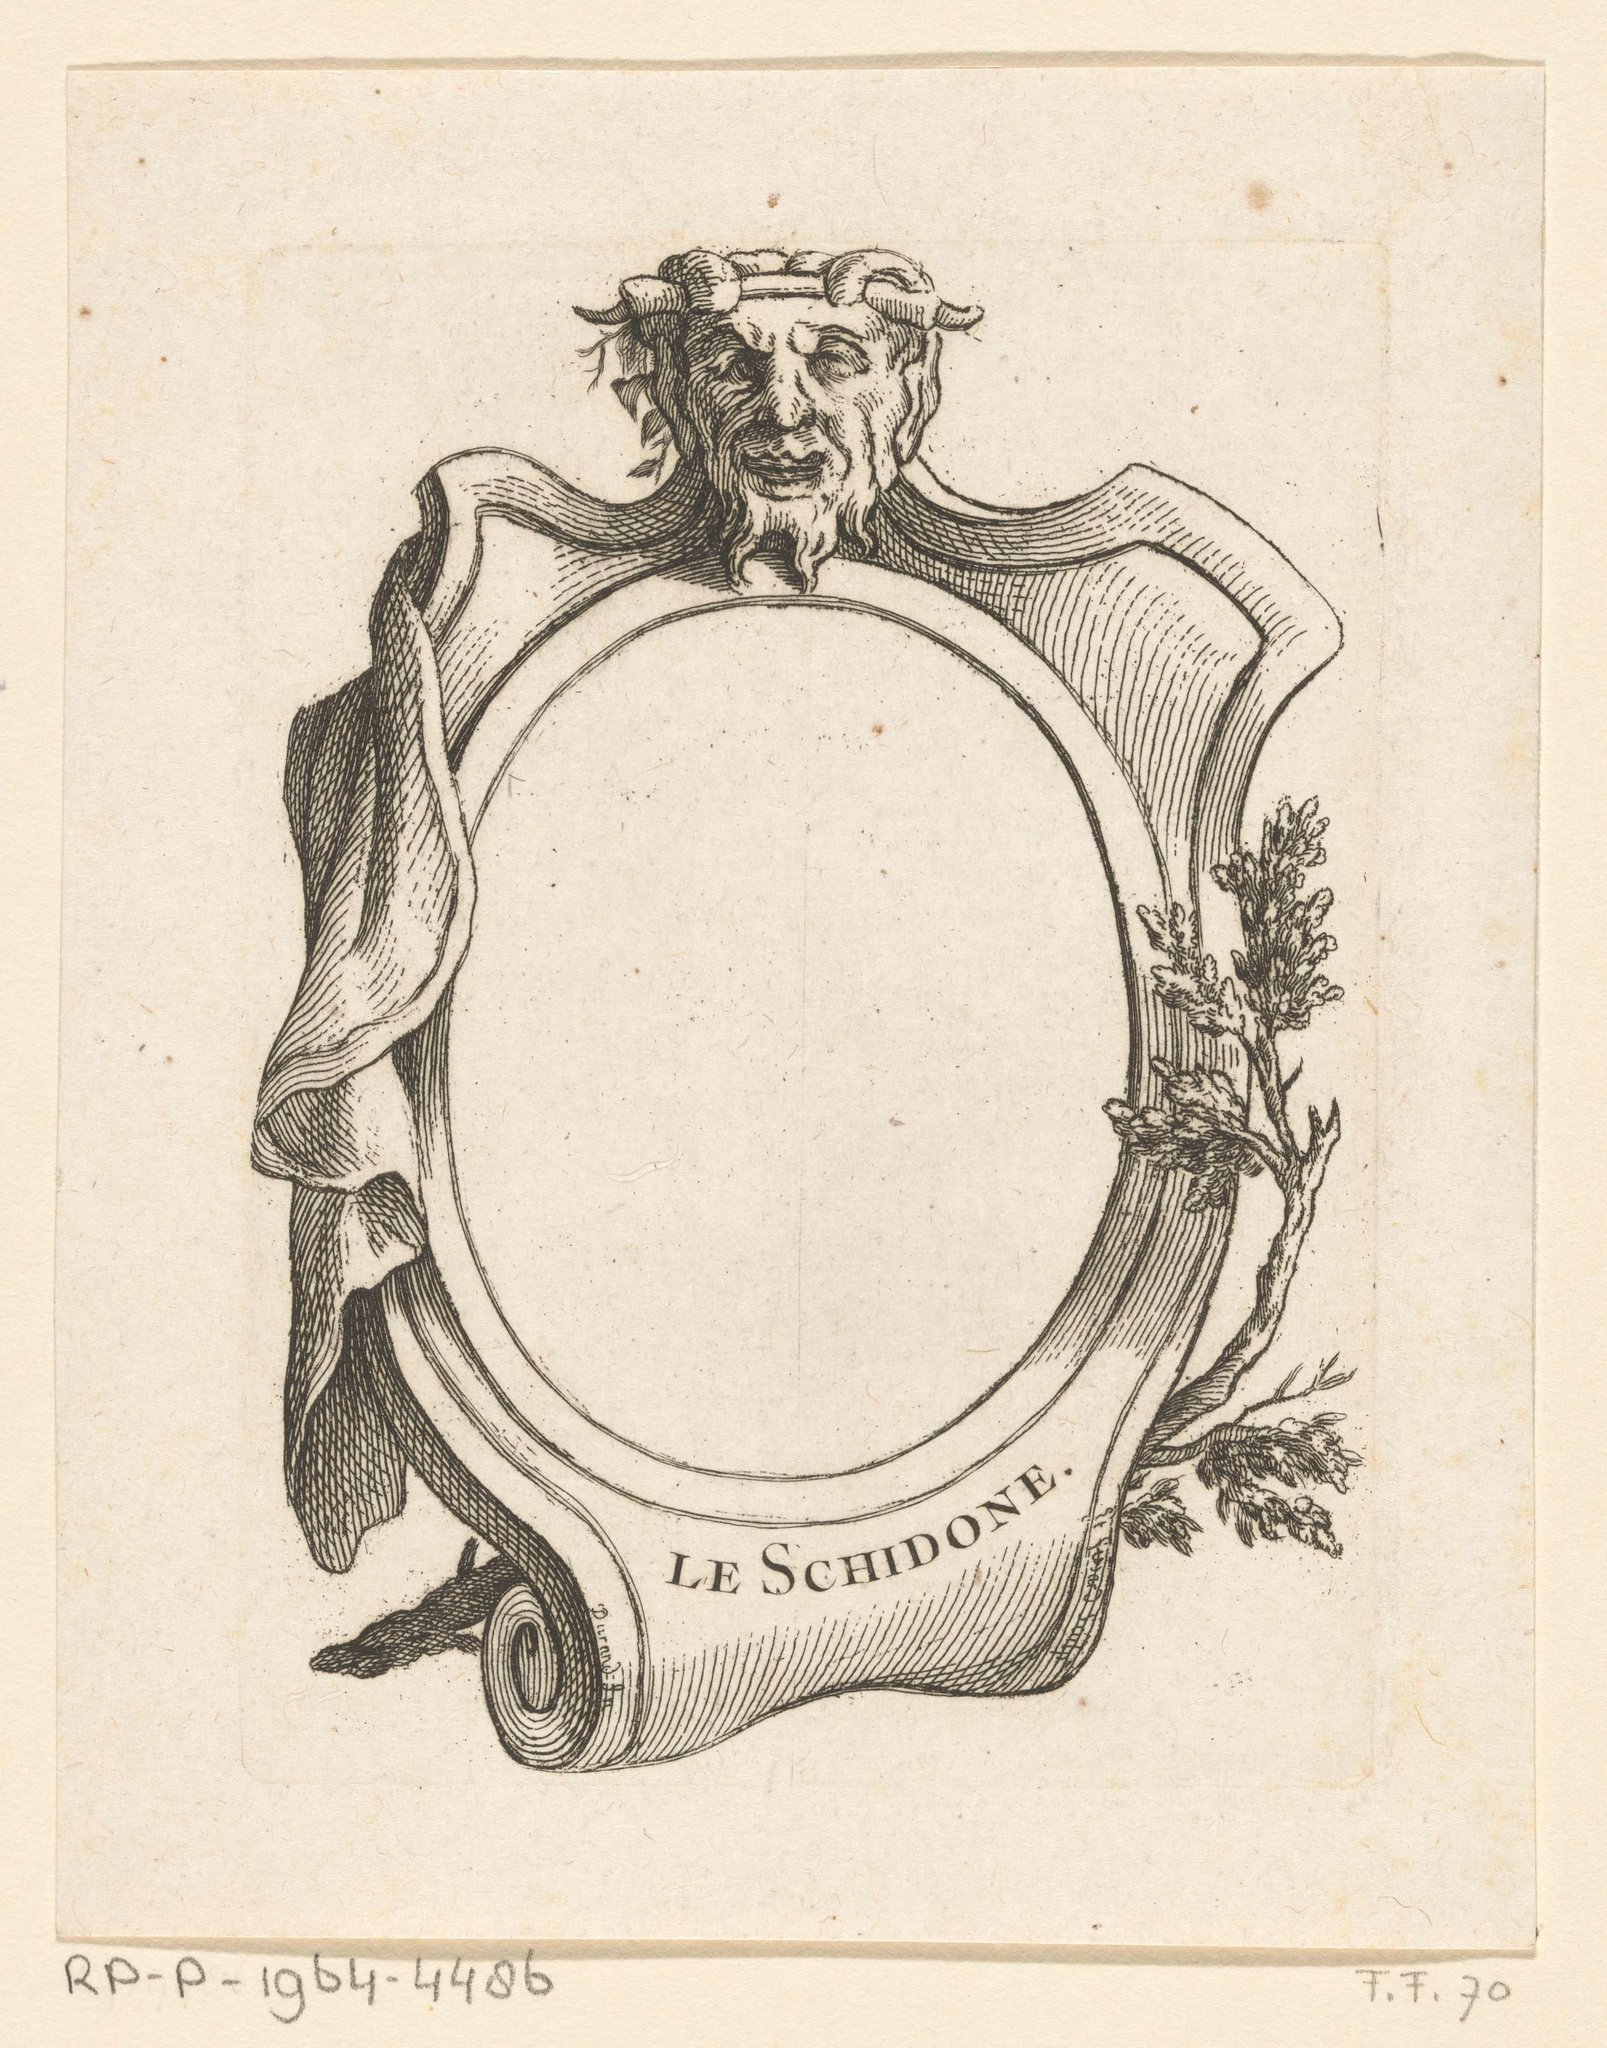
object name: print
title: Omlijstingen voor kunstenaarsportretten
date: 1724-1777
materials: paper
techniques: etching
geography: france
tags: ornaments ~ art (+ framing decorations), artist (in general)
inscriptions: collector's mark: Lugt 2228, collector's mark: Lugt 2760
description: Een ovale omlijsting met een saterkop en een tak voor Le Schidone (Bartolomeo Schedoni).